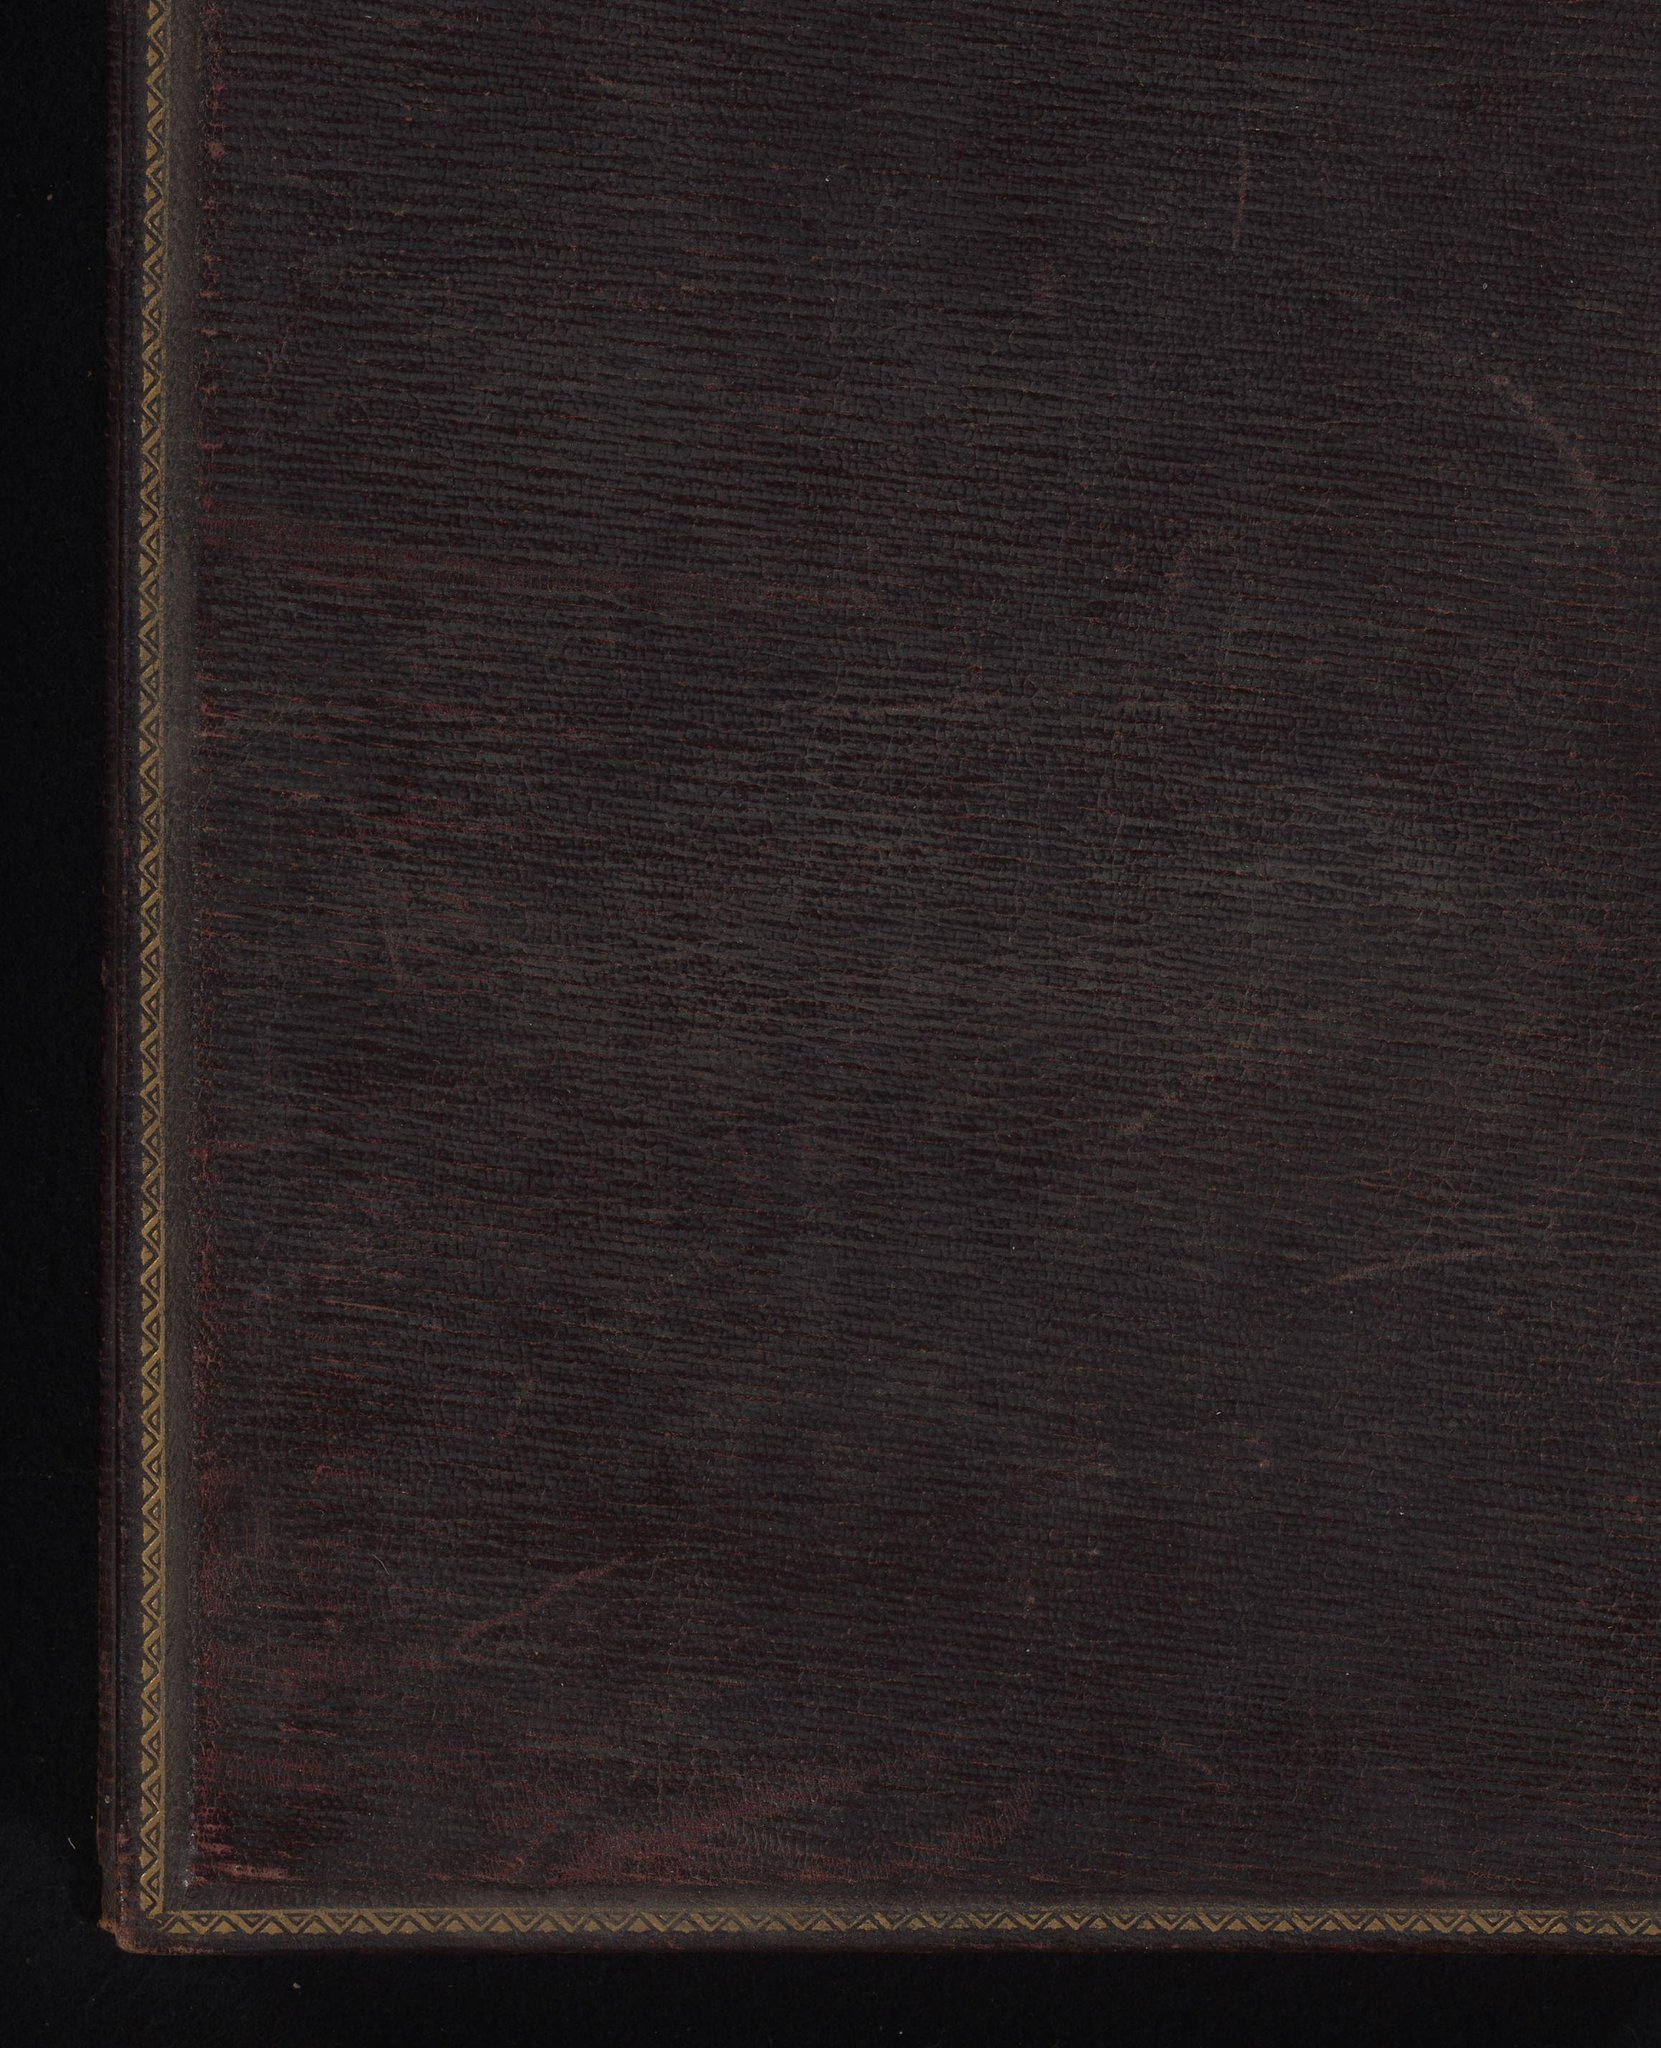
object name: box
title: Opbergdoos voor kabinetfoto's uit bezit van Carel Vosmaer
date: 1866-1888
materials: cardboard, gold leaf, leather, silk, wood